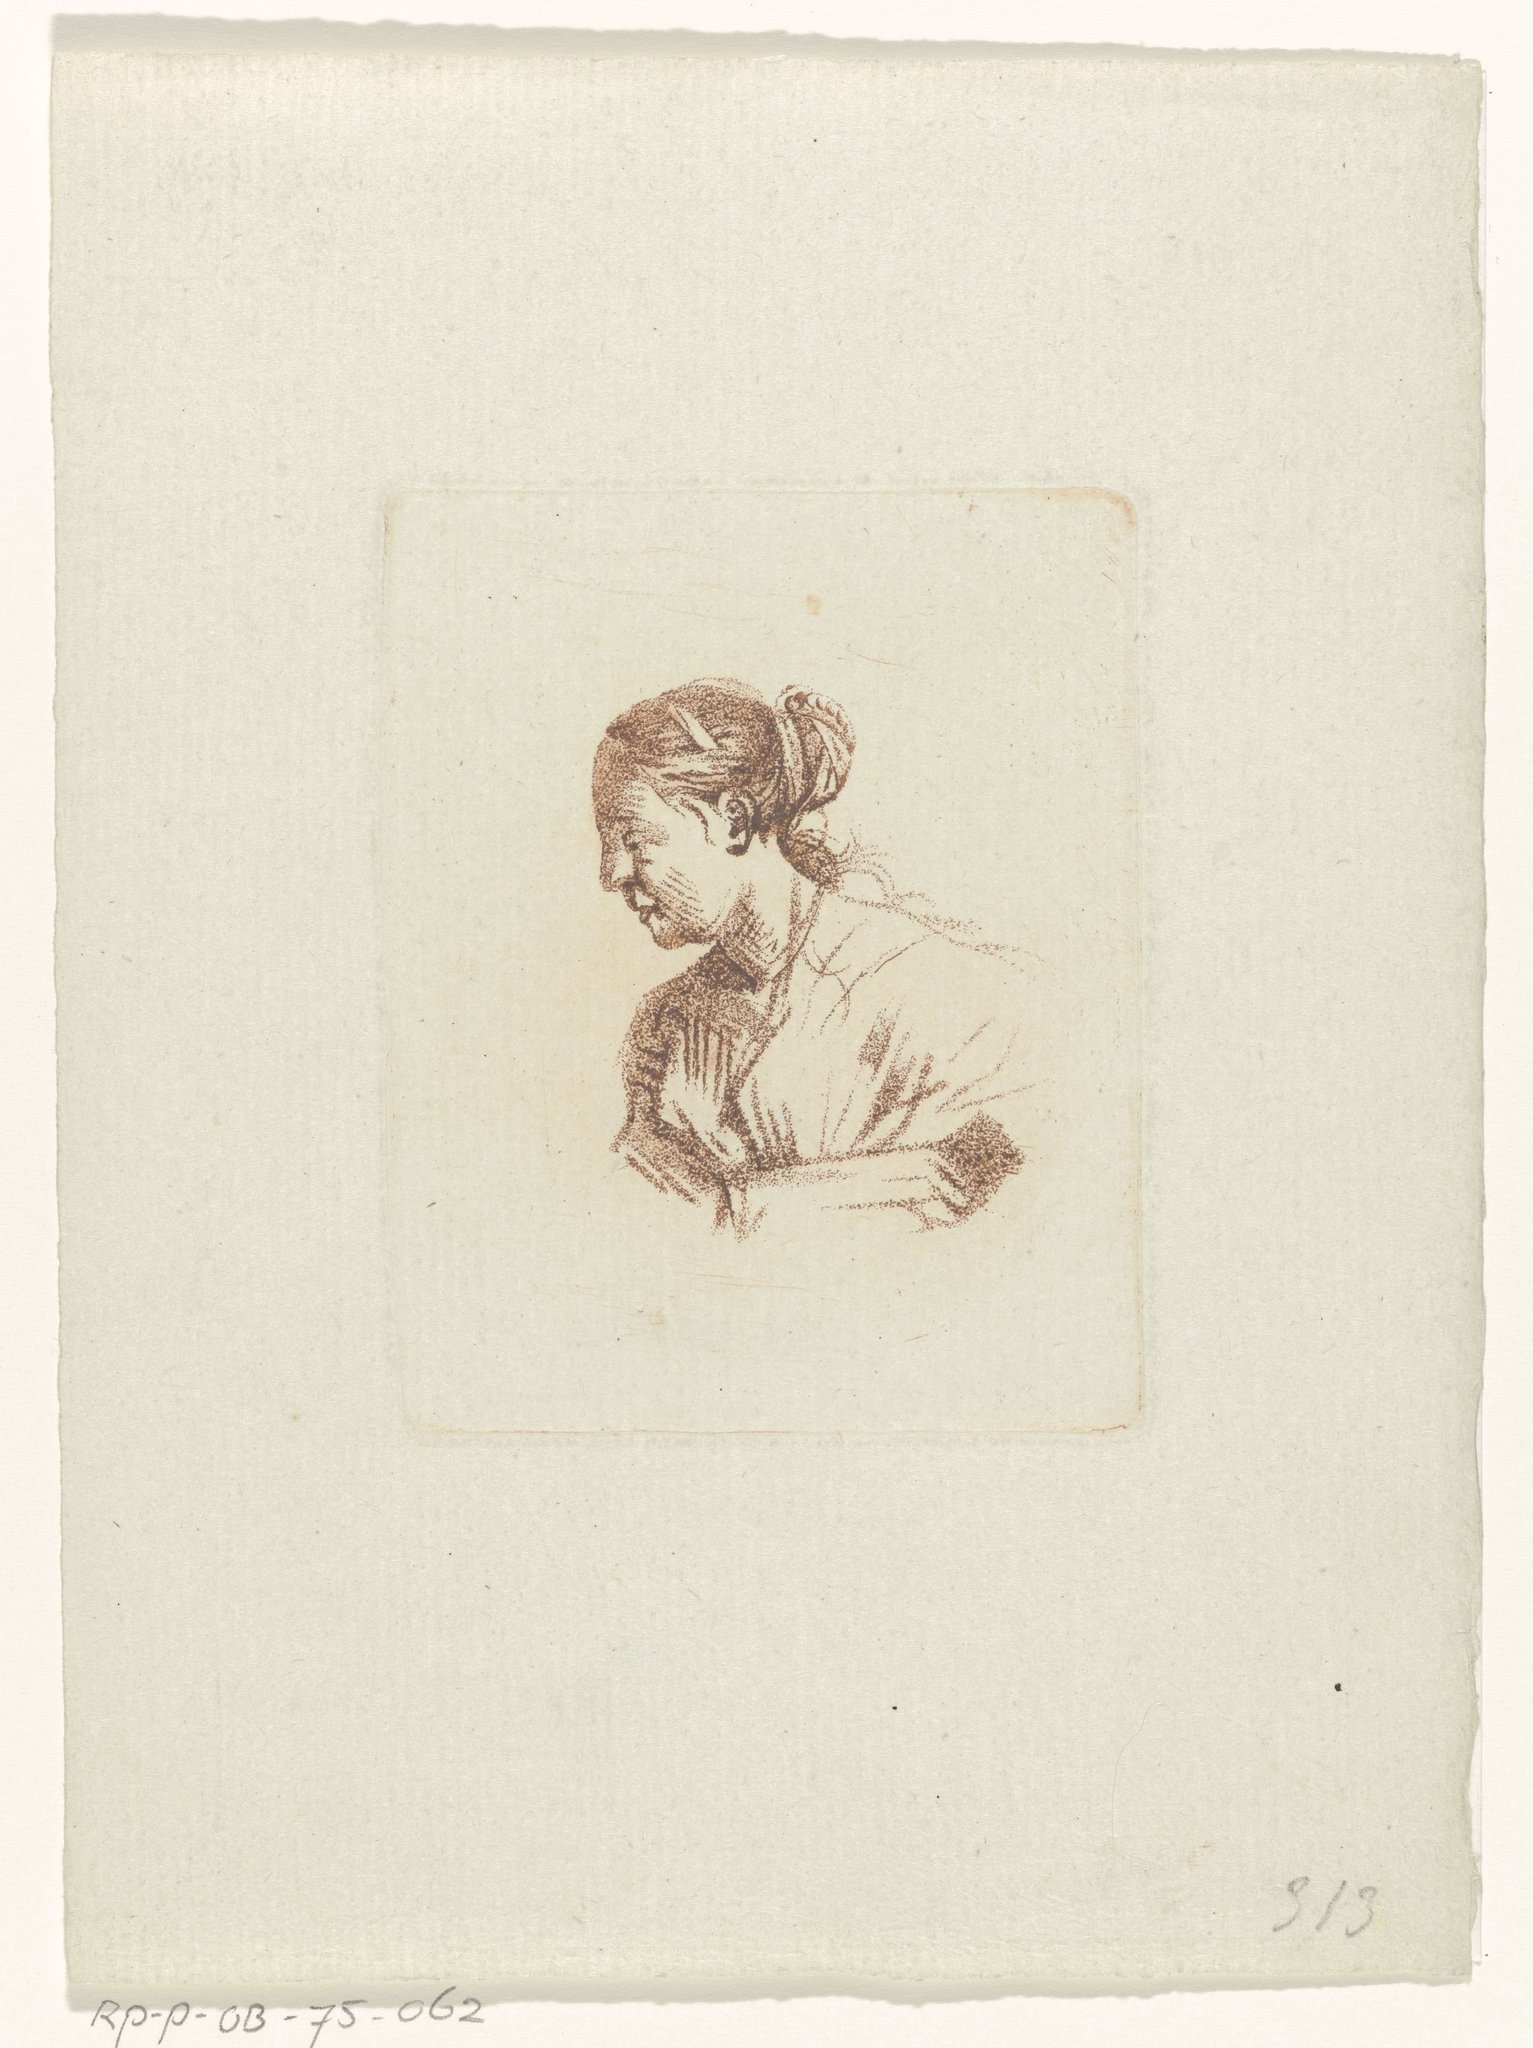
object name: print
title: Buste van een vrouw naar links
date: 1739-1851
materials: paper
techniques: stippled etching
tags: head (human) (+ sideview, profile)